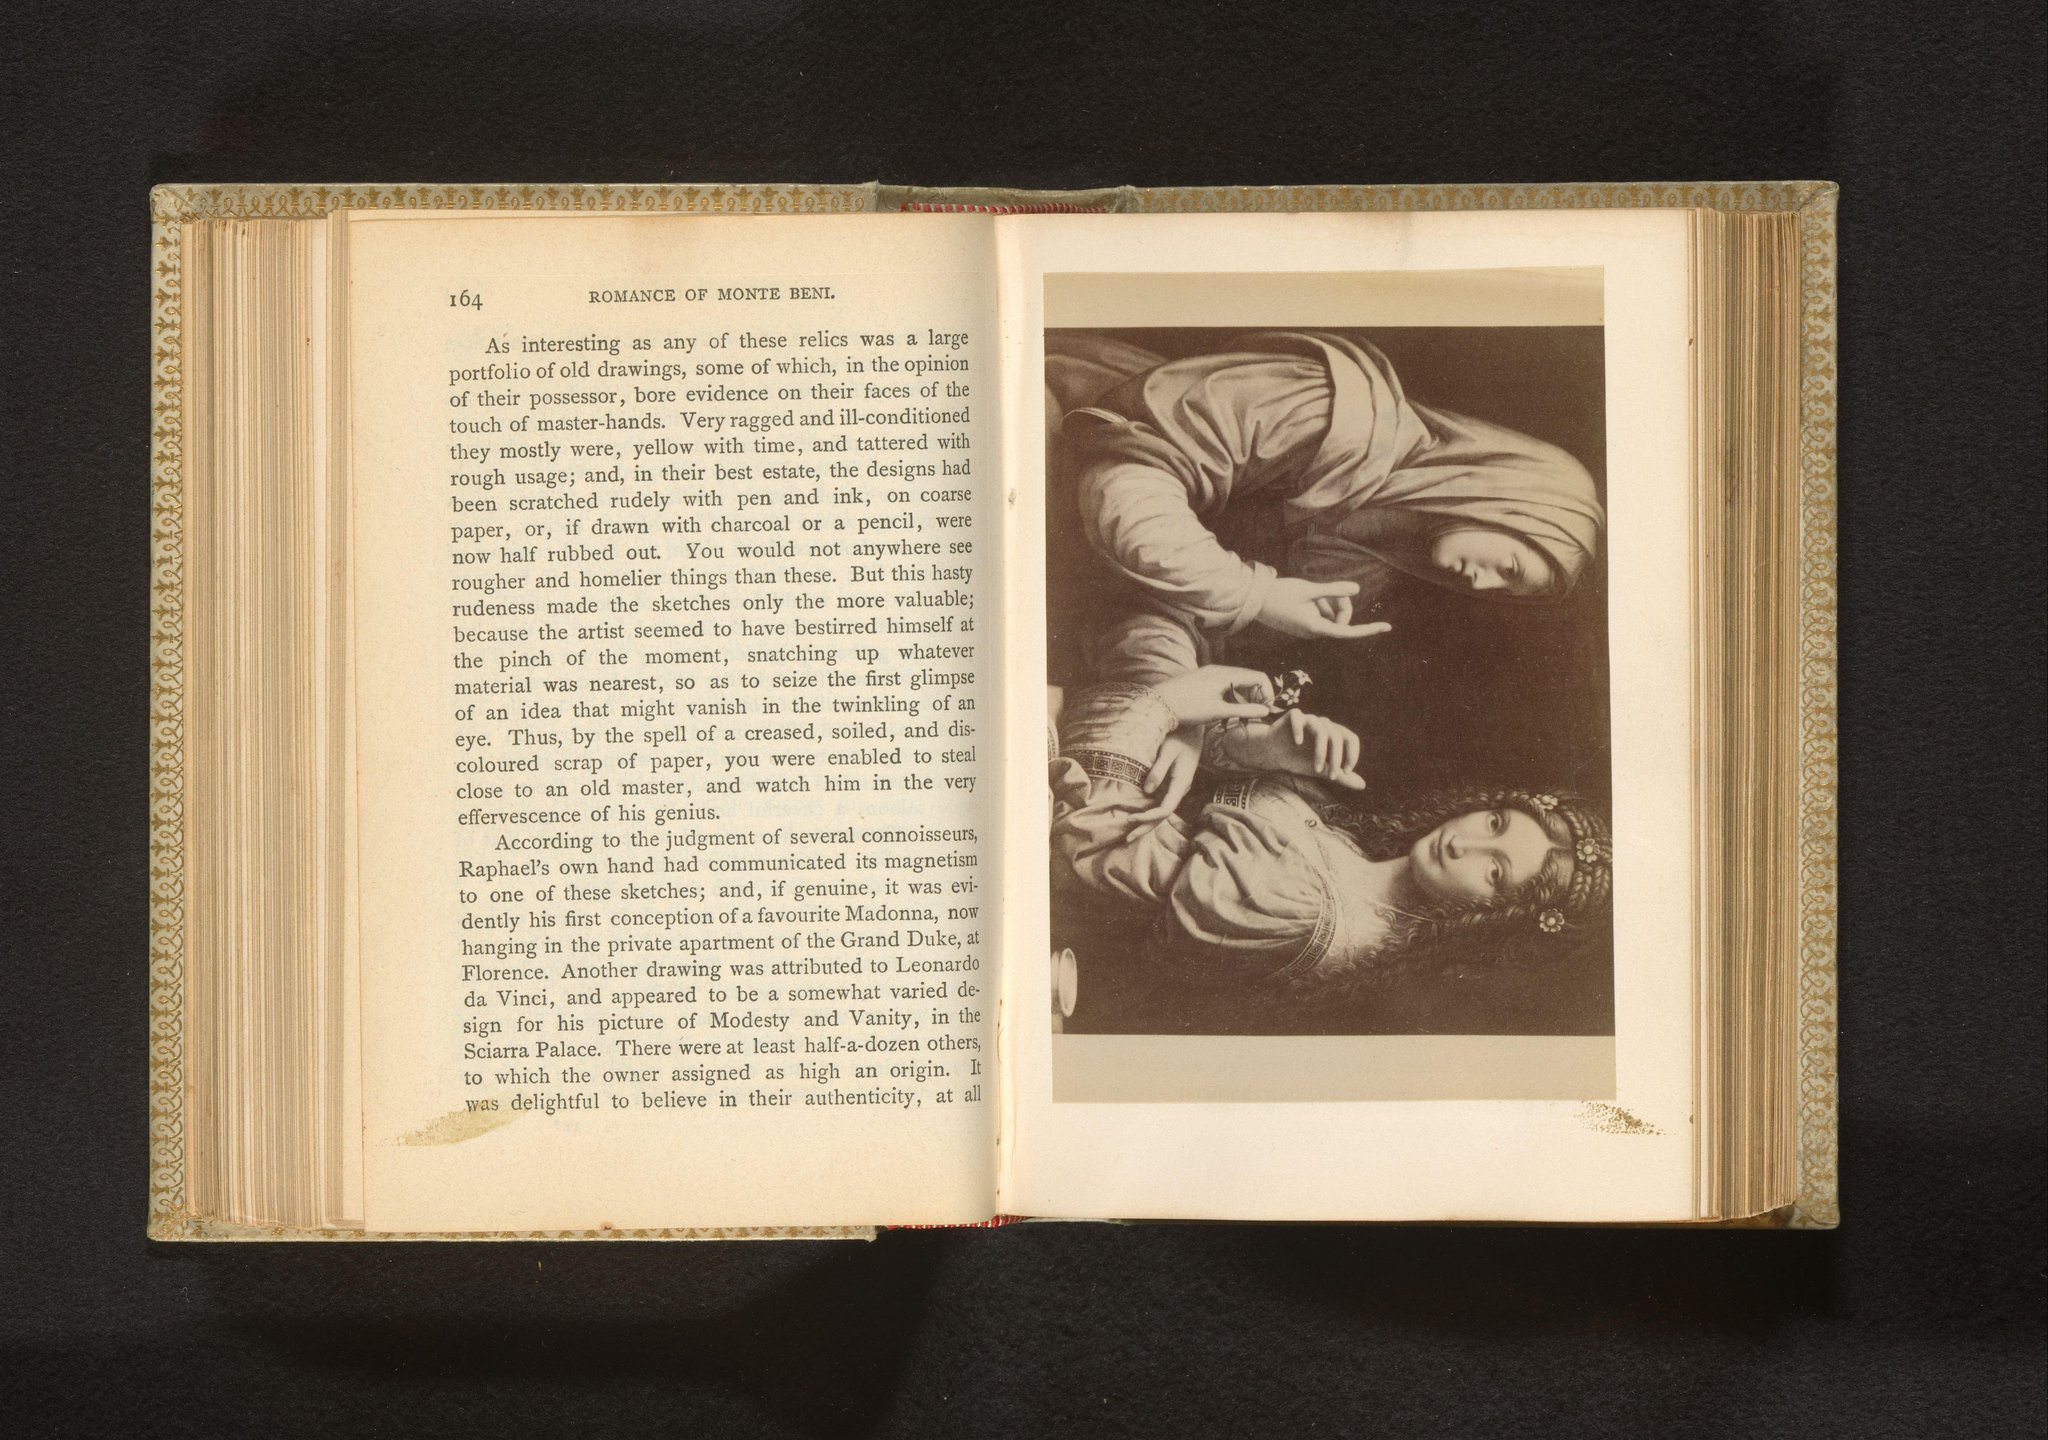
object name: page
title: Fotoreproductie van een tekening naar Modestia et Vanitas door Leonardo da Vinci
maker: Anonymous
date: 1850-1860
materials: photographic support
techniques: albumen print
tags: drawing